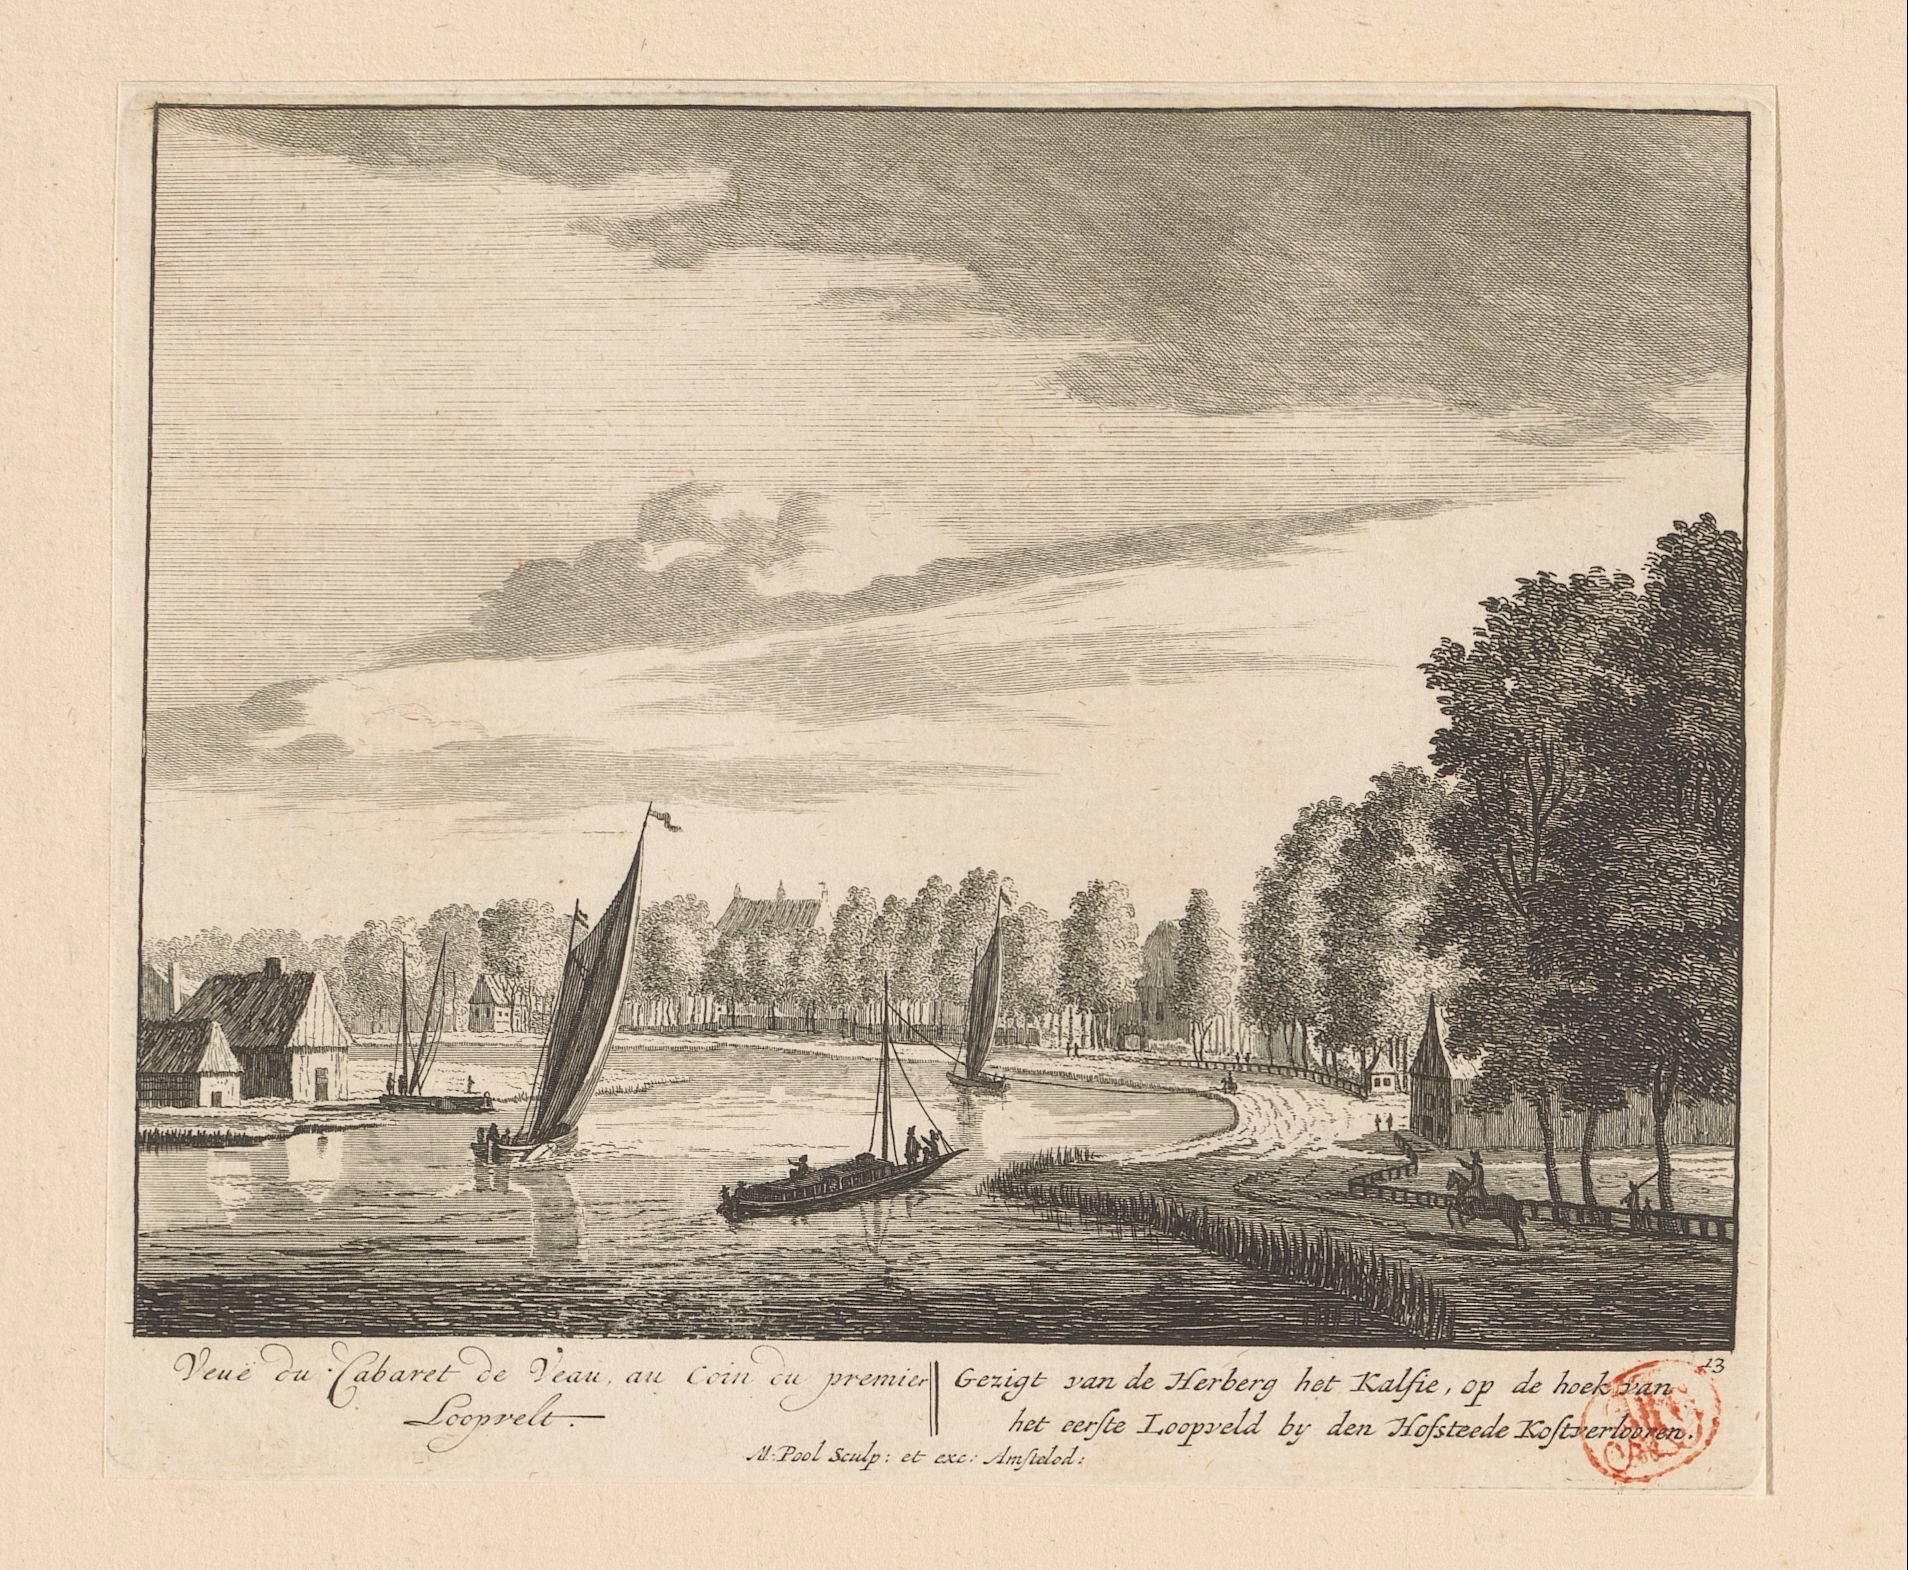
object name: print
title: Gezicht op de Amstel bij herberg het Kalfje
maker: matthijs pool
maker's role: print maker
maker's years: 1676-1740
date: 1708-1740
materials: paper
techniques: engraving, etching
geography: amsterdam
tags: sailing-ship, sailing-boat, castle, river, hotel, hostelry, inn, boat propelled by man or animal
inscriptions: collector's mark: Lugt 2233, collector's mark: Lugt 195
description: Prent gebruikt in: Pool, Matthijs. Verscheyde gesigten van de vermaarde rievier de buyten Amstel van de stadt Amsterdam, tot het dorp Ouwerkerk (…) / Plusieurs veuës et perspectives de la fameuse riviére de Buyten-Amstel depuis Amsterdam jusqu'au village d'Ouwerkerk (…). Amsterdam: Matthijs Pool, z.j. [1708-1740].